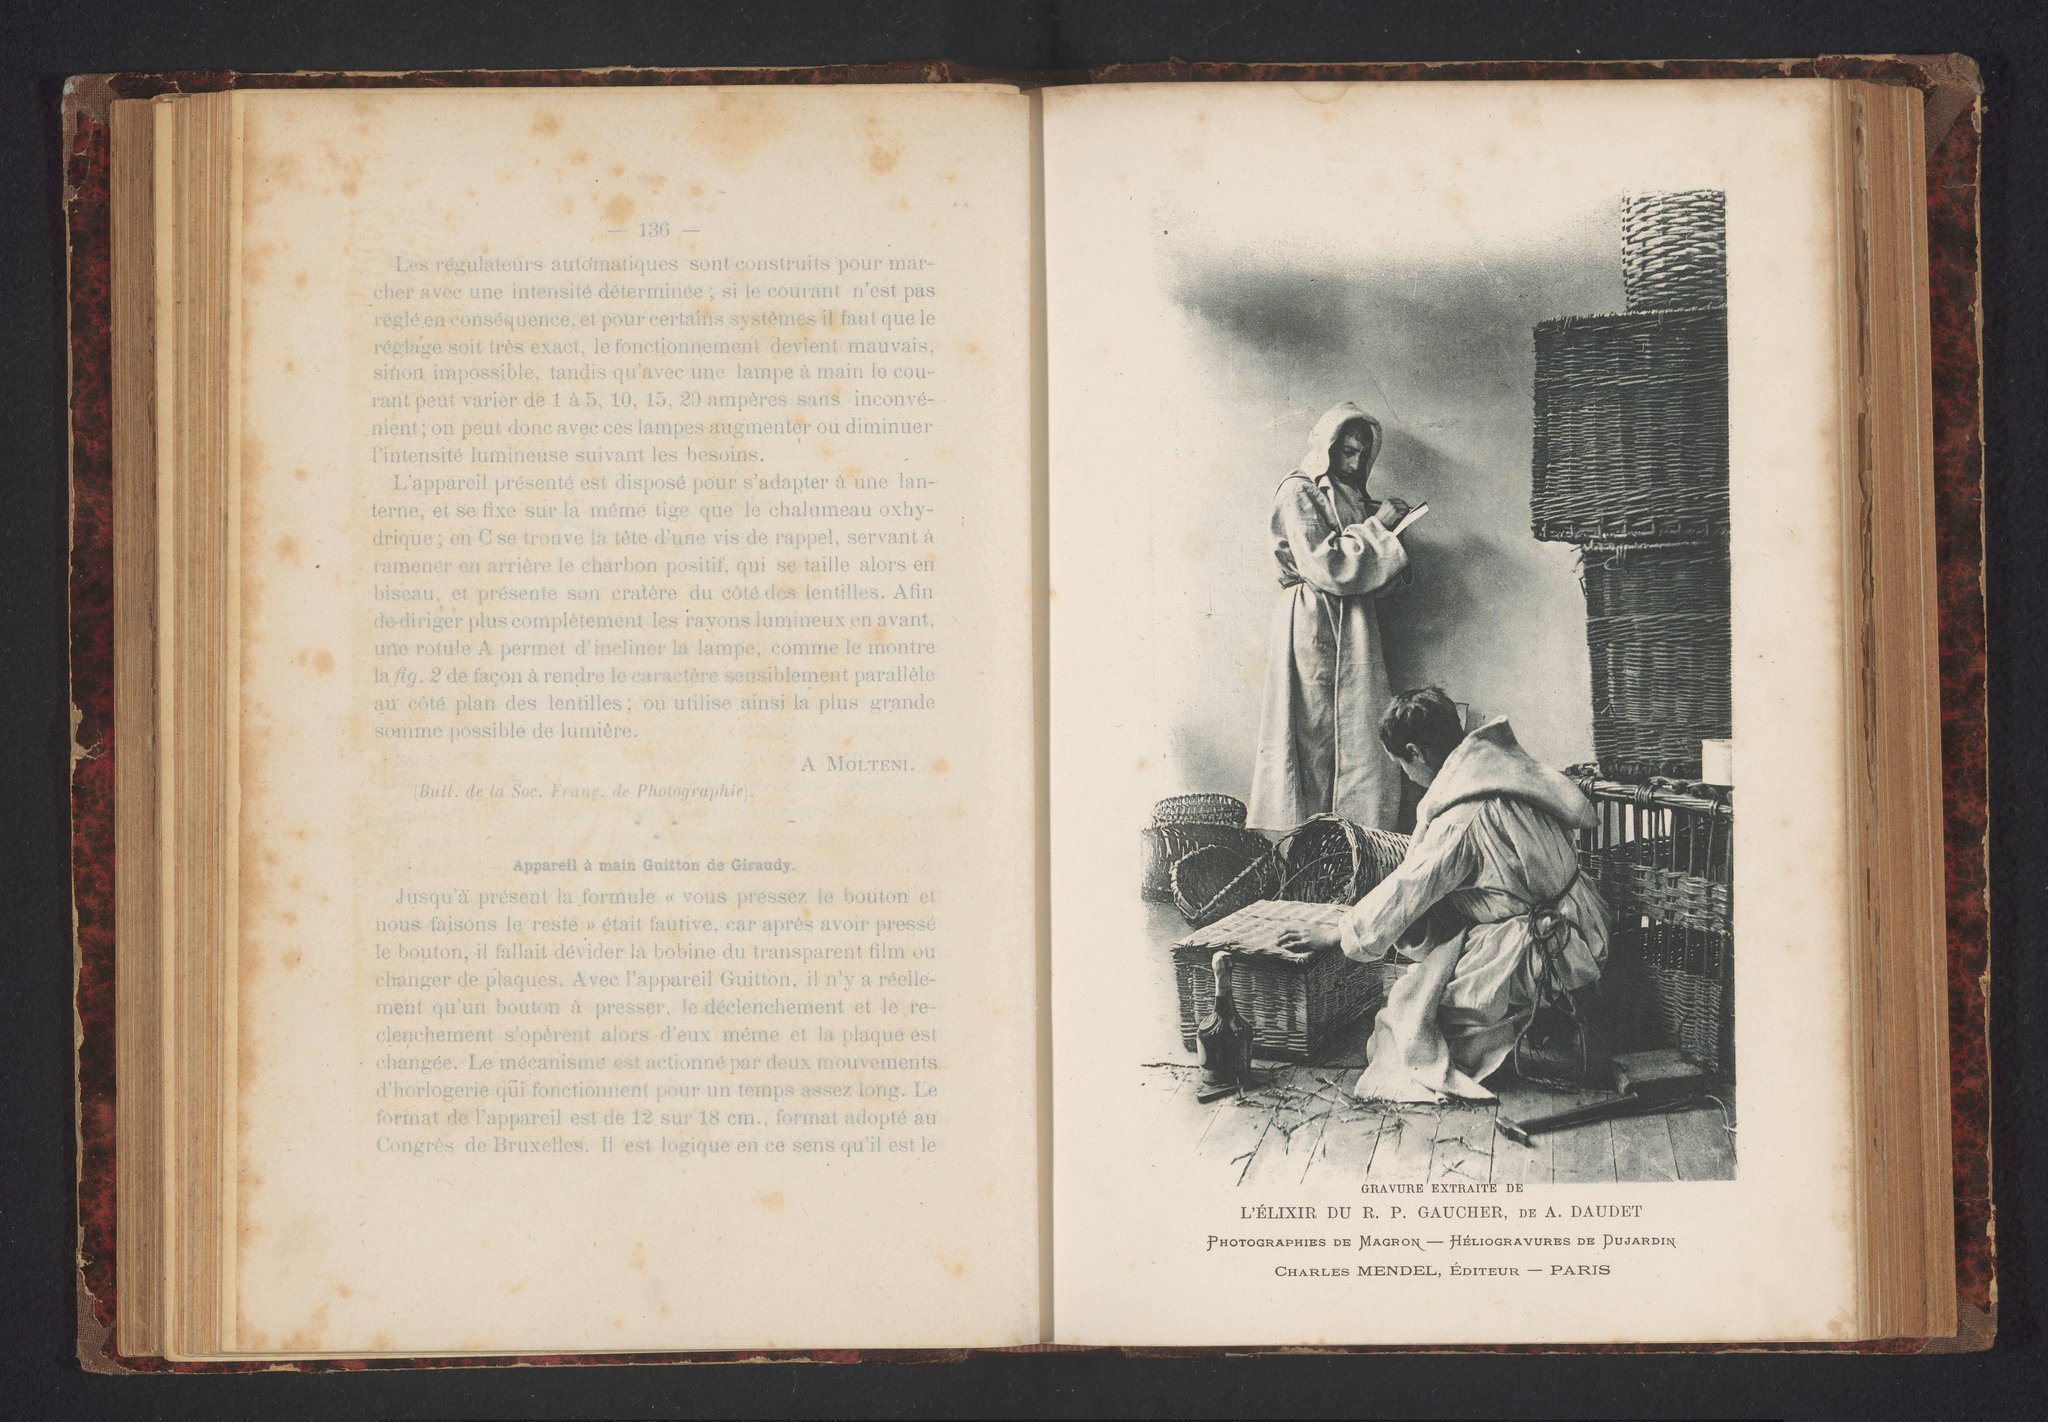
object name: page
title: Twee monniken met rieten manden en een fles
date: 1890-1895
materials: paper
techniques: photoaquatint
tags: container made of plant material other than wood: basket, monk(s), friar(s)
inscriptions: inscription: ‘Gravure extraite de l'élixir du R.P. Gaucher, de A. Daudet’